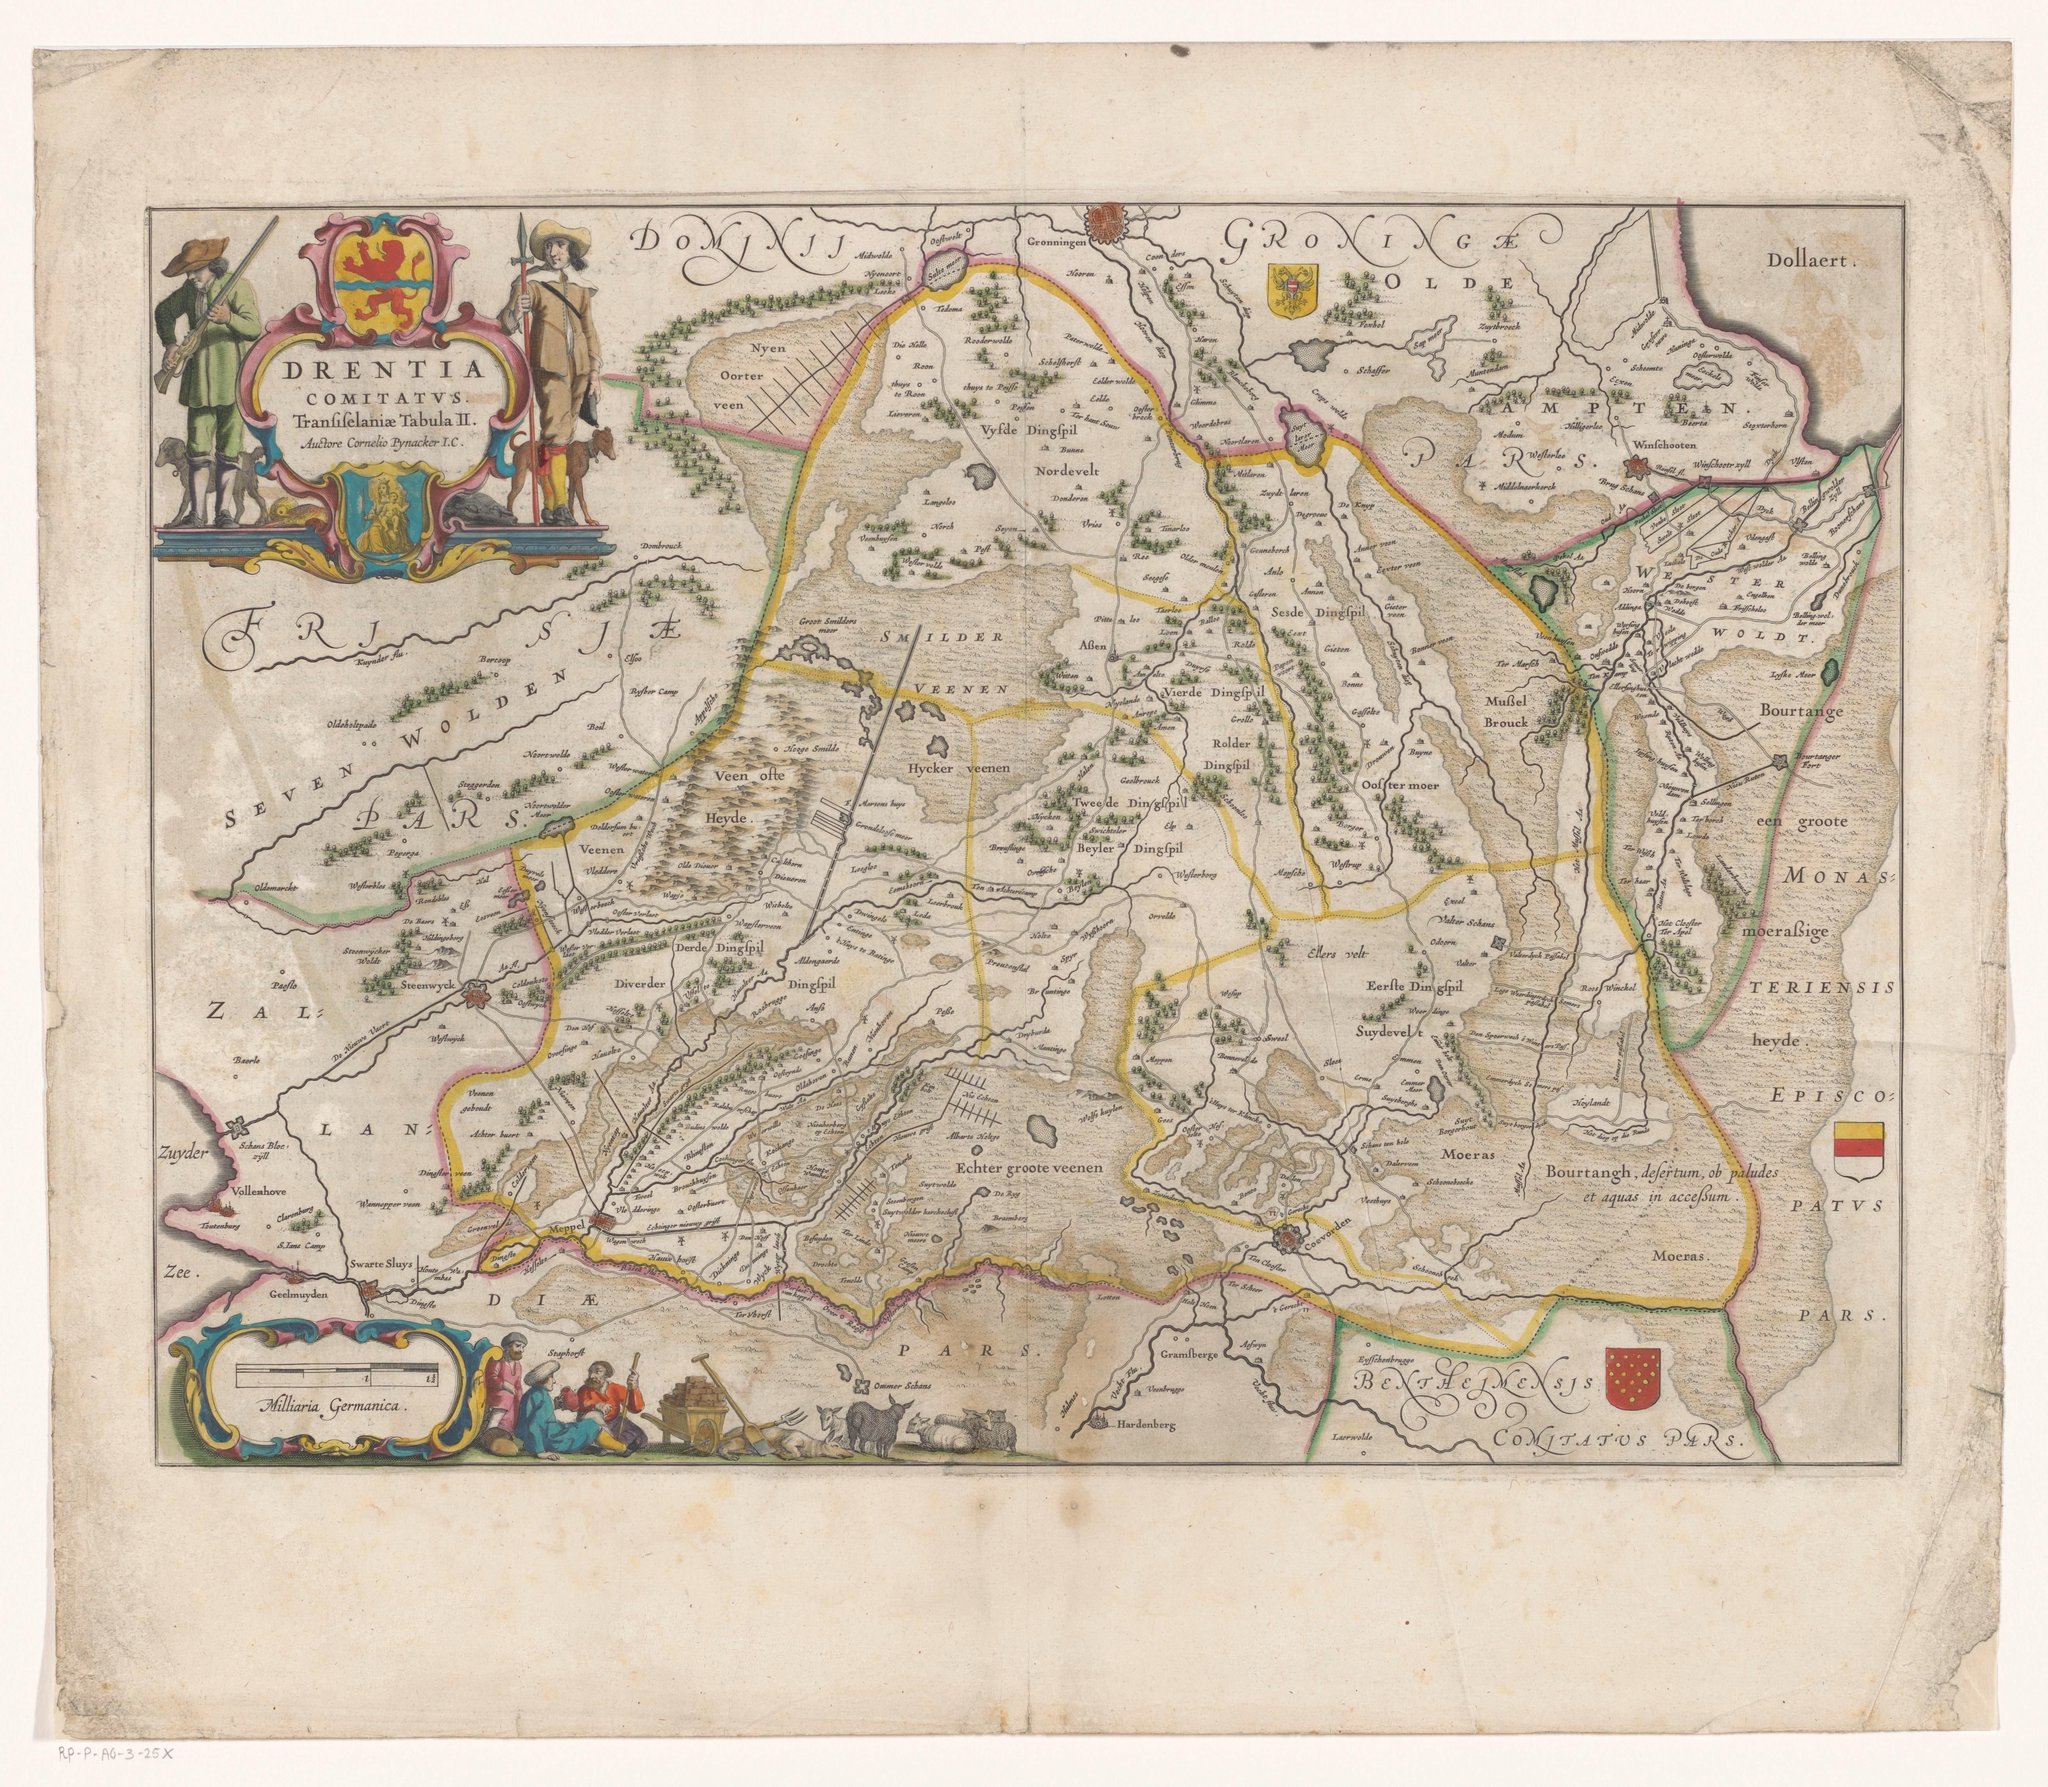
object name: print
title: Kaart van Drenthe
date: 1642-1661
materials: paper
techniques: engraving, hand coloring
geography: amsterdam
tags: peat (soil type), coat of arms (as symbol of the state, etc.), maps of separate countries or regions, hunter, agriculture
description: Prent of gebruikt in: Blaeu, Willem Janszoon en Johannes Willemszoon Blaeu. Toonneel des aerdriicx, ofte nieuwe Atlas, dat is de beschryving van alle landen. 3 delen. Amsterdam: Johannes Willemszoon Blaeu, 1642-1643, dl. 1 (1642). Of in: Blaeu, Willem Janszoon en Johannes Willemszoon Blaeu. Toonneel des aerdrycx, ofte nieuwe Atlas, dat is de beschryving van alle landen. 4 delen. Amsterdam: Johannes Willemszoon Blaeu, 1647-1650, dl. 1 (1647-1648). Of in: Blaeu, Willem Janszoon en Johannes Willemszoon Blaeu. Toonneel des aerdrycx, ofte nieuwe Atlas, dat is de beschryving van alle landen. 4 delen. Amsterdam: Johannes Willemszoon Blaeu, 1649-1650, dl. 1 (1649). Of in: Blaeu, Willem Janszoon en Johannes Willemszoon Blaeu. Toonneel des aerdriicx, ofte niuew Atlas, dat is beschryving van alle landen. 6 delen. Amsterdam: Johannes Willemszoon Blaeu, 1658-1661, dl. 1.